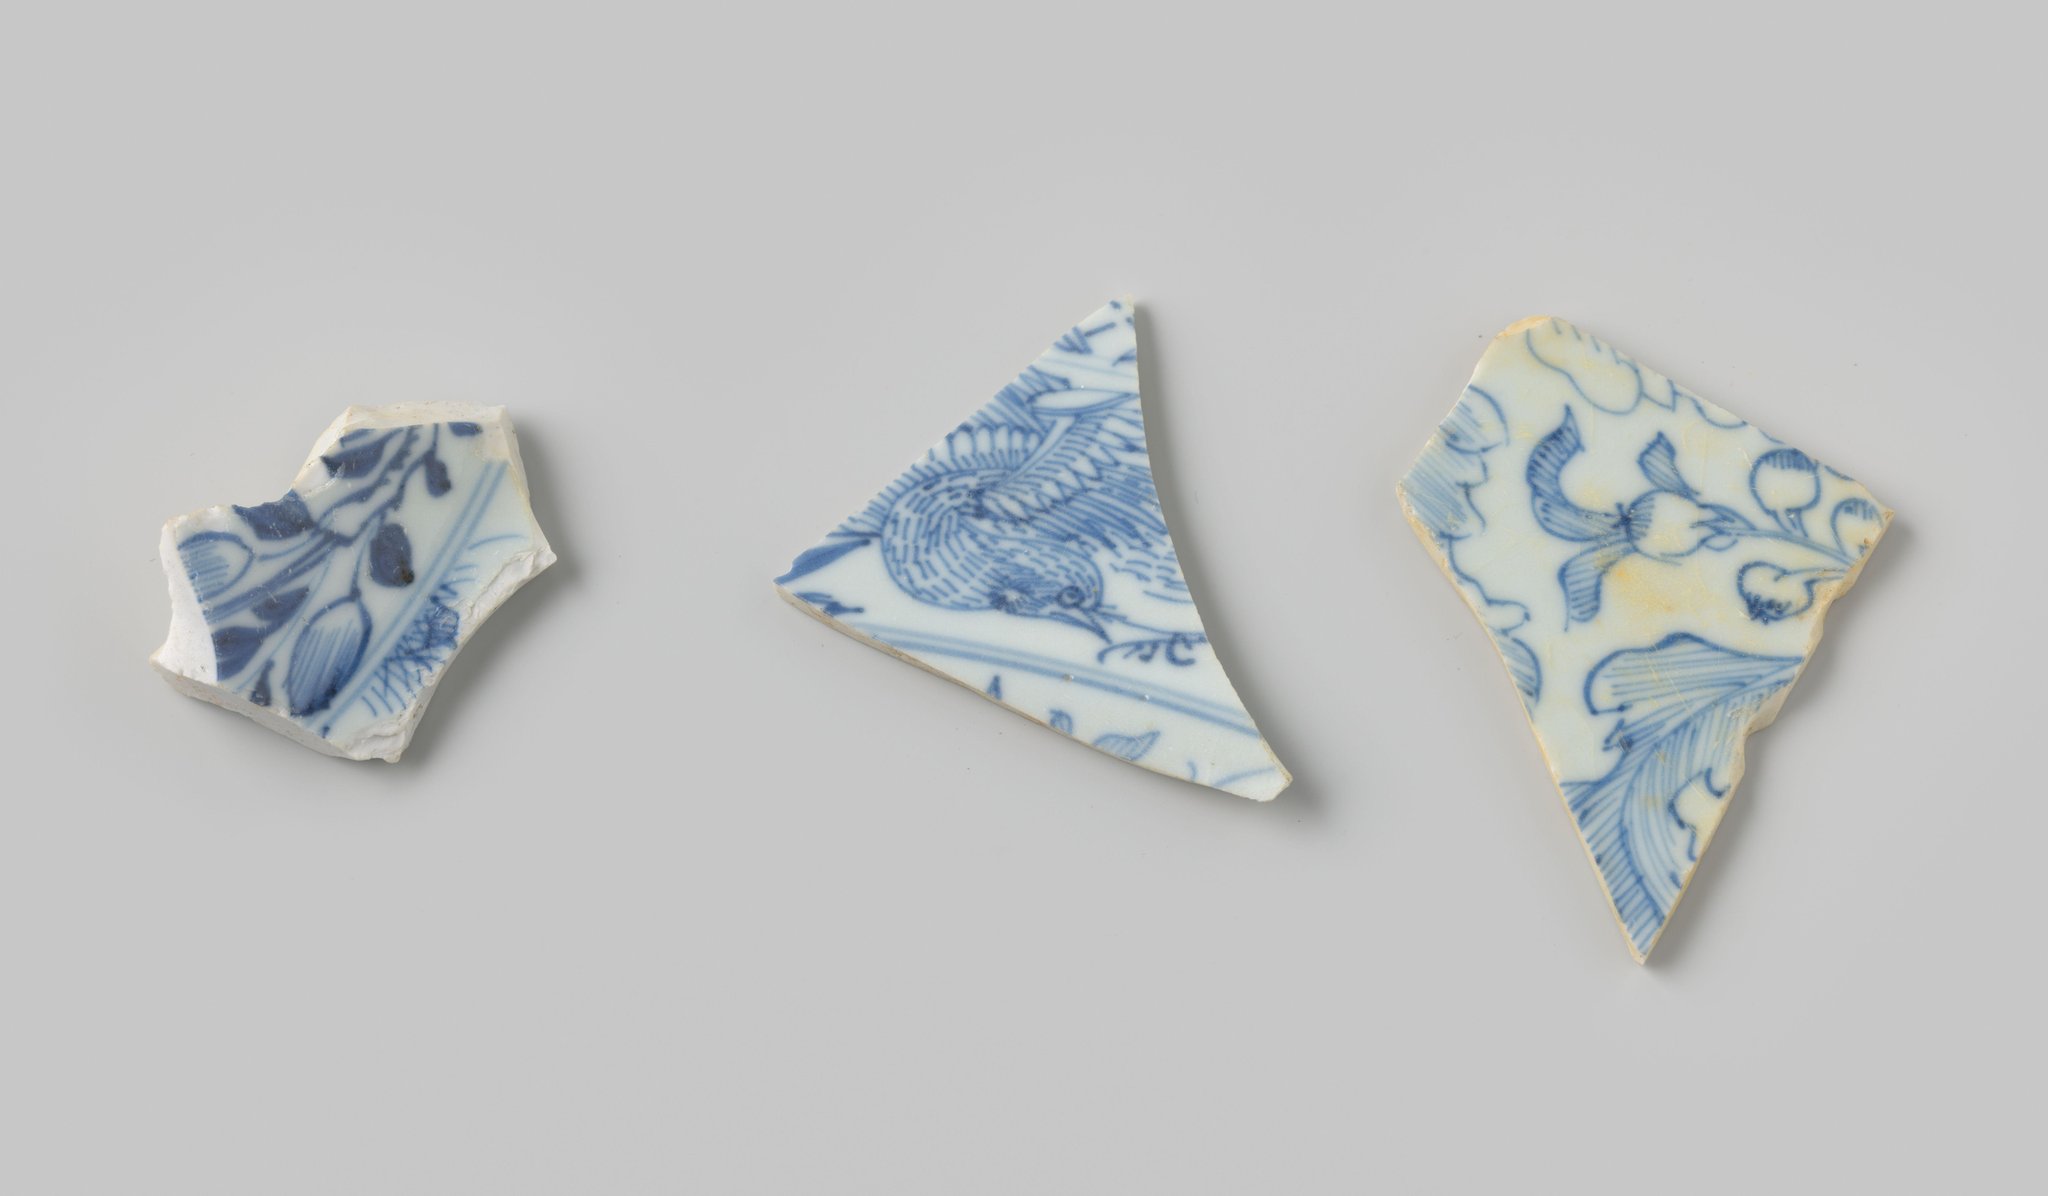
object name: sherd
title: Scherven van een bord uit het wrak van de Oost-Indiëvaarder Hollandia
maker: Anonymous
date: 1700-1743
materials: porcelain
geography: netherlands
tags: verenigde oostindische compagnie, hollandia (schip), annet